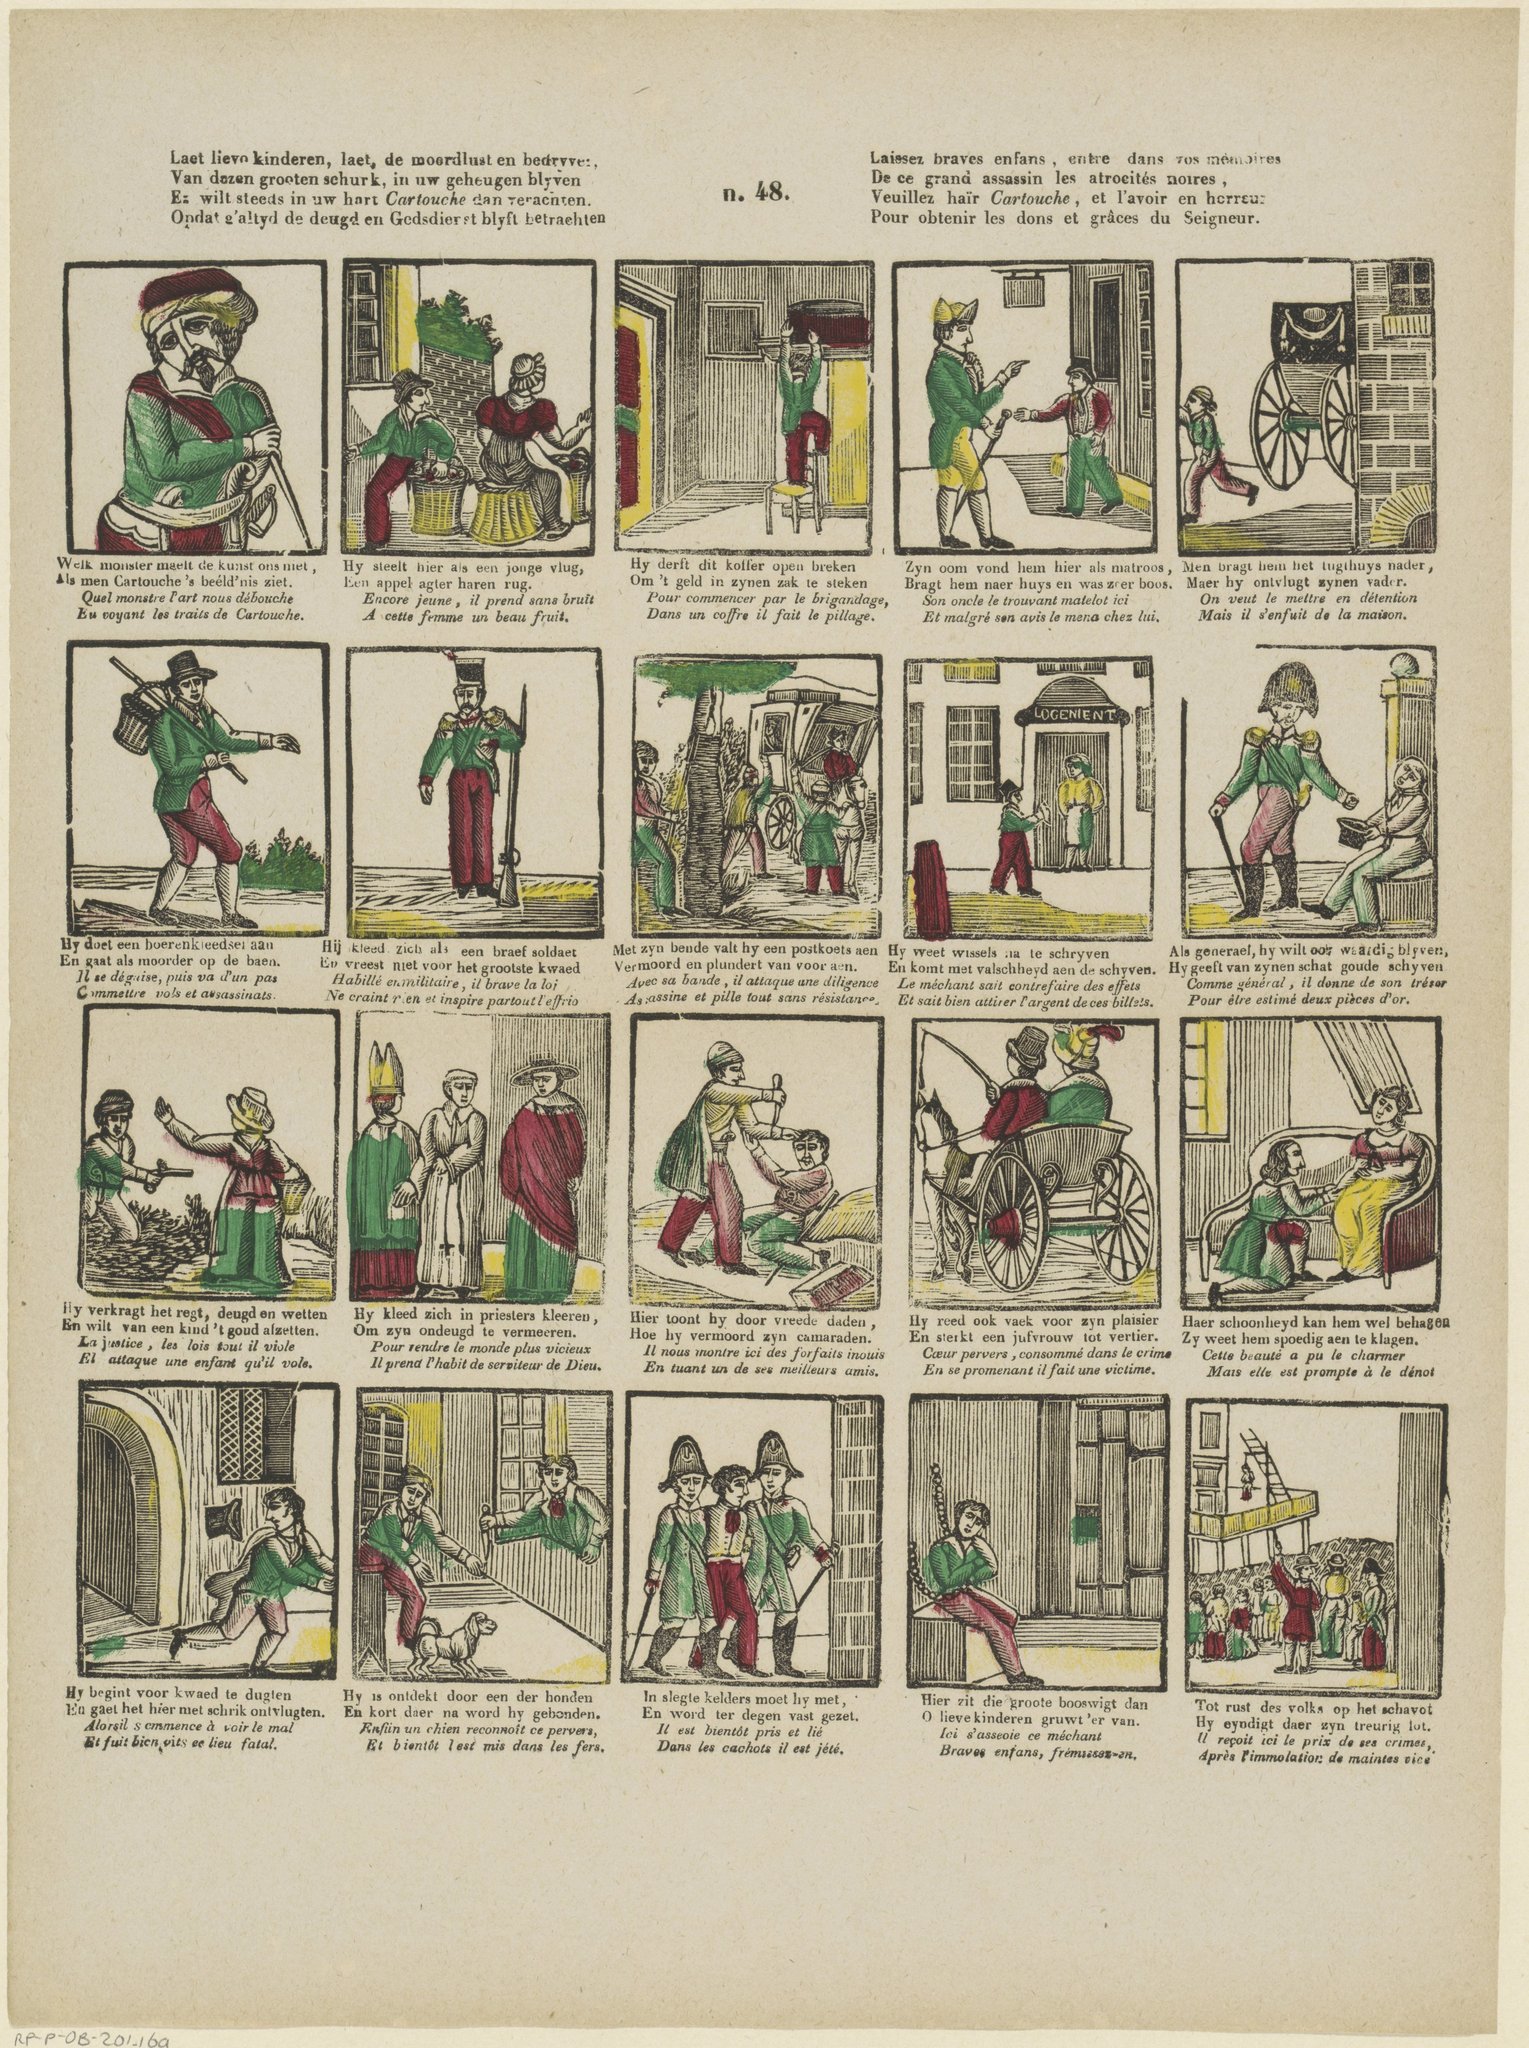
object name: popular print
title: Laet lieve kinderen, laet de moordlust en bedryve: / Van dezen grooten schurk, in uw geheugen blijven (...)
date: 1866-1902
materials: paper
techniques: colour, letterpress printing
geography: turnhout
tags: violent death by hanging, bad behaviour, tales and fairy tales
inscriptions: collector's mark: Lugt 2760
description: Blad met 20 voorstellingen over het leven en de avonturen van Cartouche. Onder elke afbeelding een tweeregelig vers in het Nederlands en in het Frans. Genummerd midden boven: n. 48.